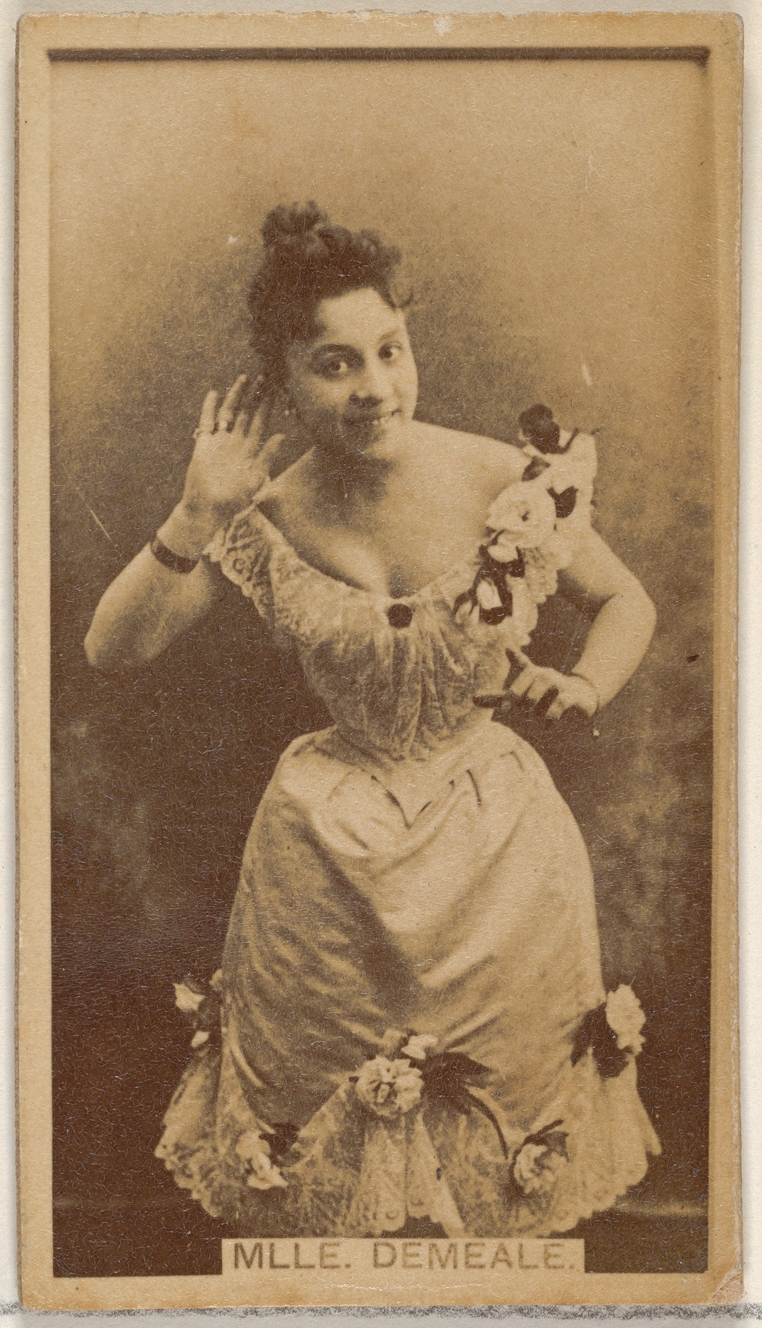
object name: photograph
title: Mlle. Demeale, from the Actors and Actresses series (N45, Type 8) for Virginia Brights Cigarettes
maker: allen & ginter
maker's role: publisher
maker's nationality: american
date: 1888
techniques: albumen silver print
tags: portraits,women,actresses